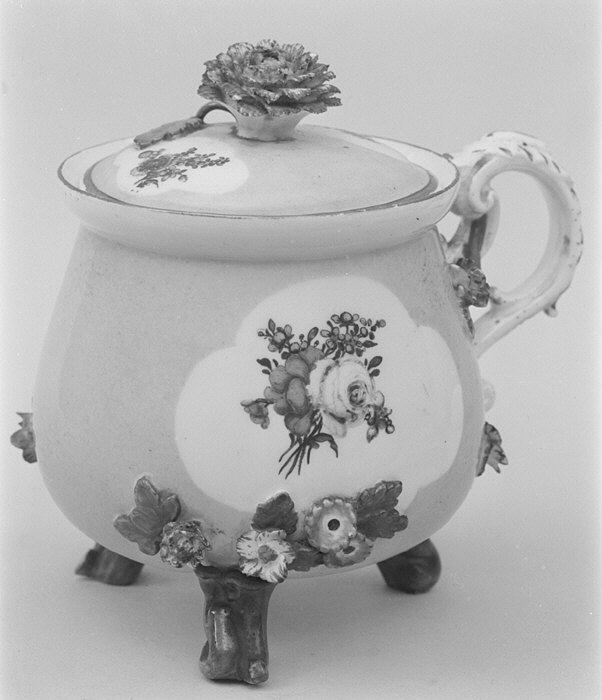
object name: cup with cover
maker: meissen manufactory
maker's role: manufactory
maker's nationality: german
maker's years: 1710-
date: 1740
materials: hard paste porcelain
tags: flowers